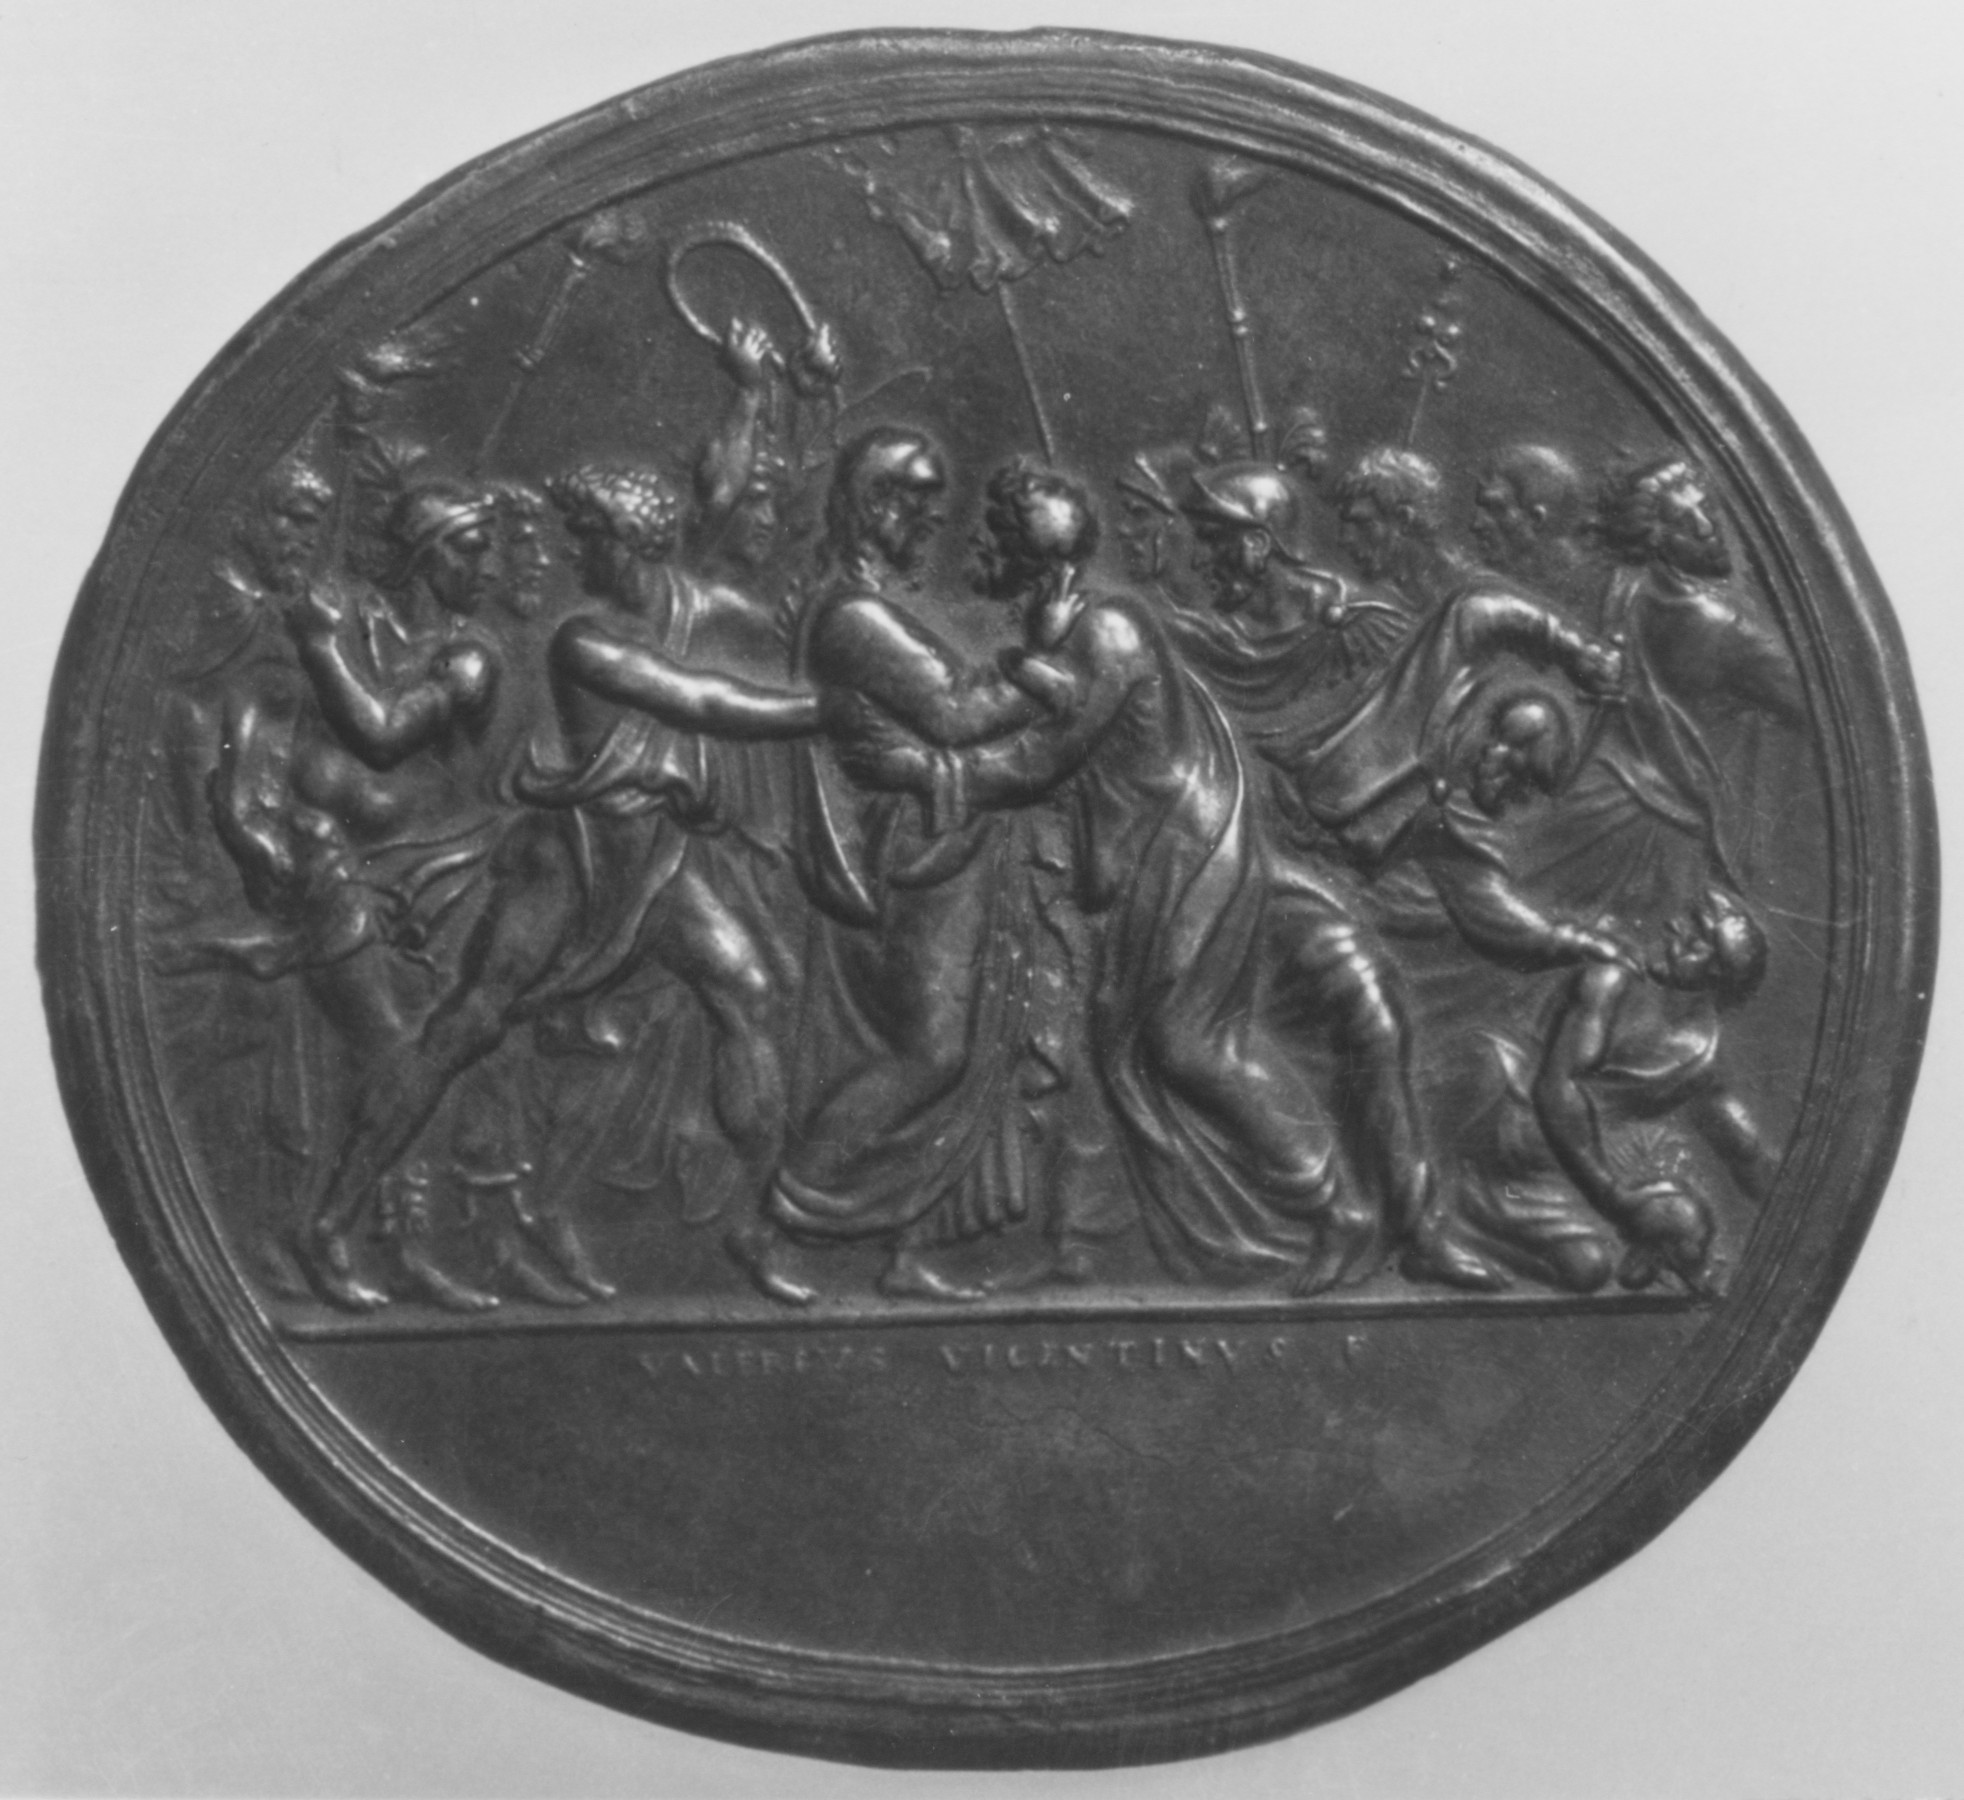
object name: plaquette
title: The Betrayal of Christ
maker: valerio belli (il vicentino)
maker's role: artist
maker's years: 1468-1546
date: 1501-1550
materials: bronze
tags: men,christ